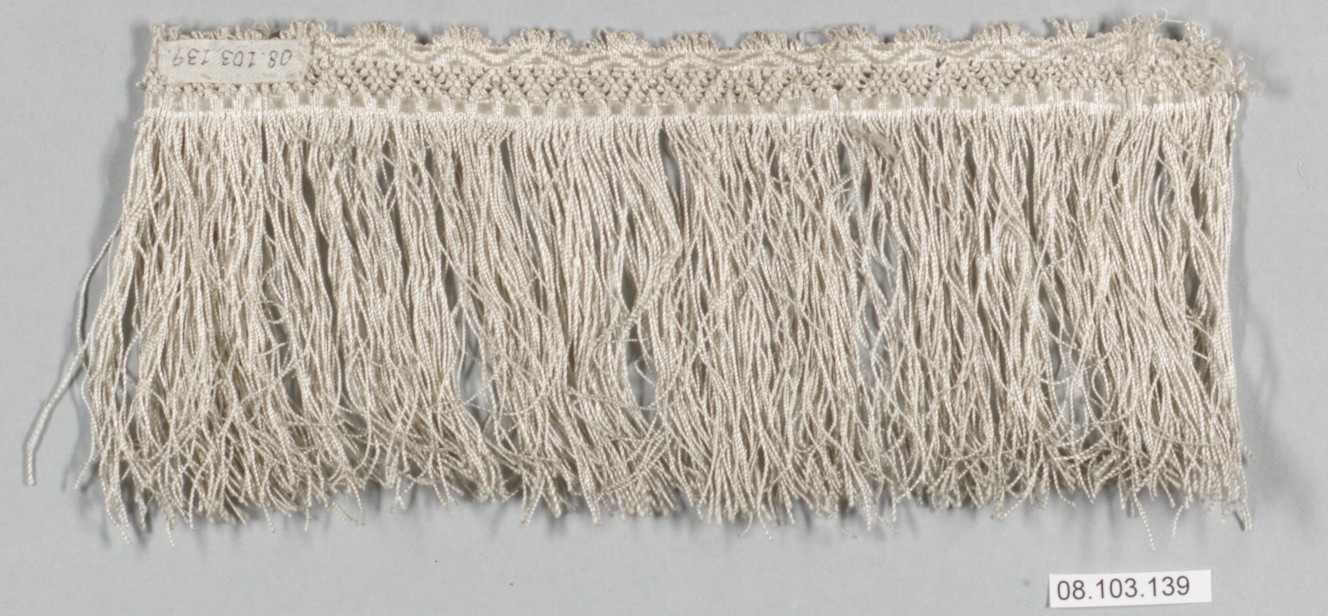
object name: fringe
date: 1880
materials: silk